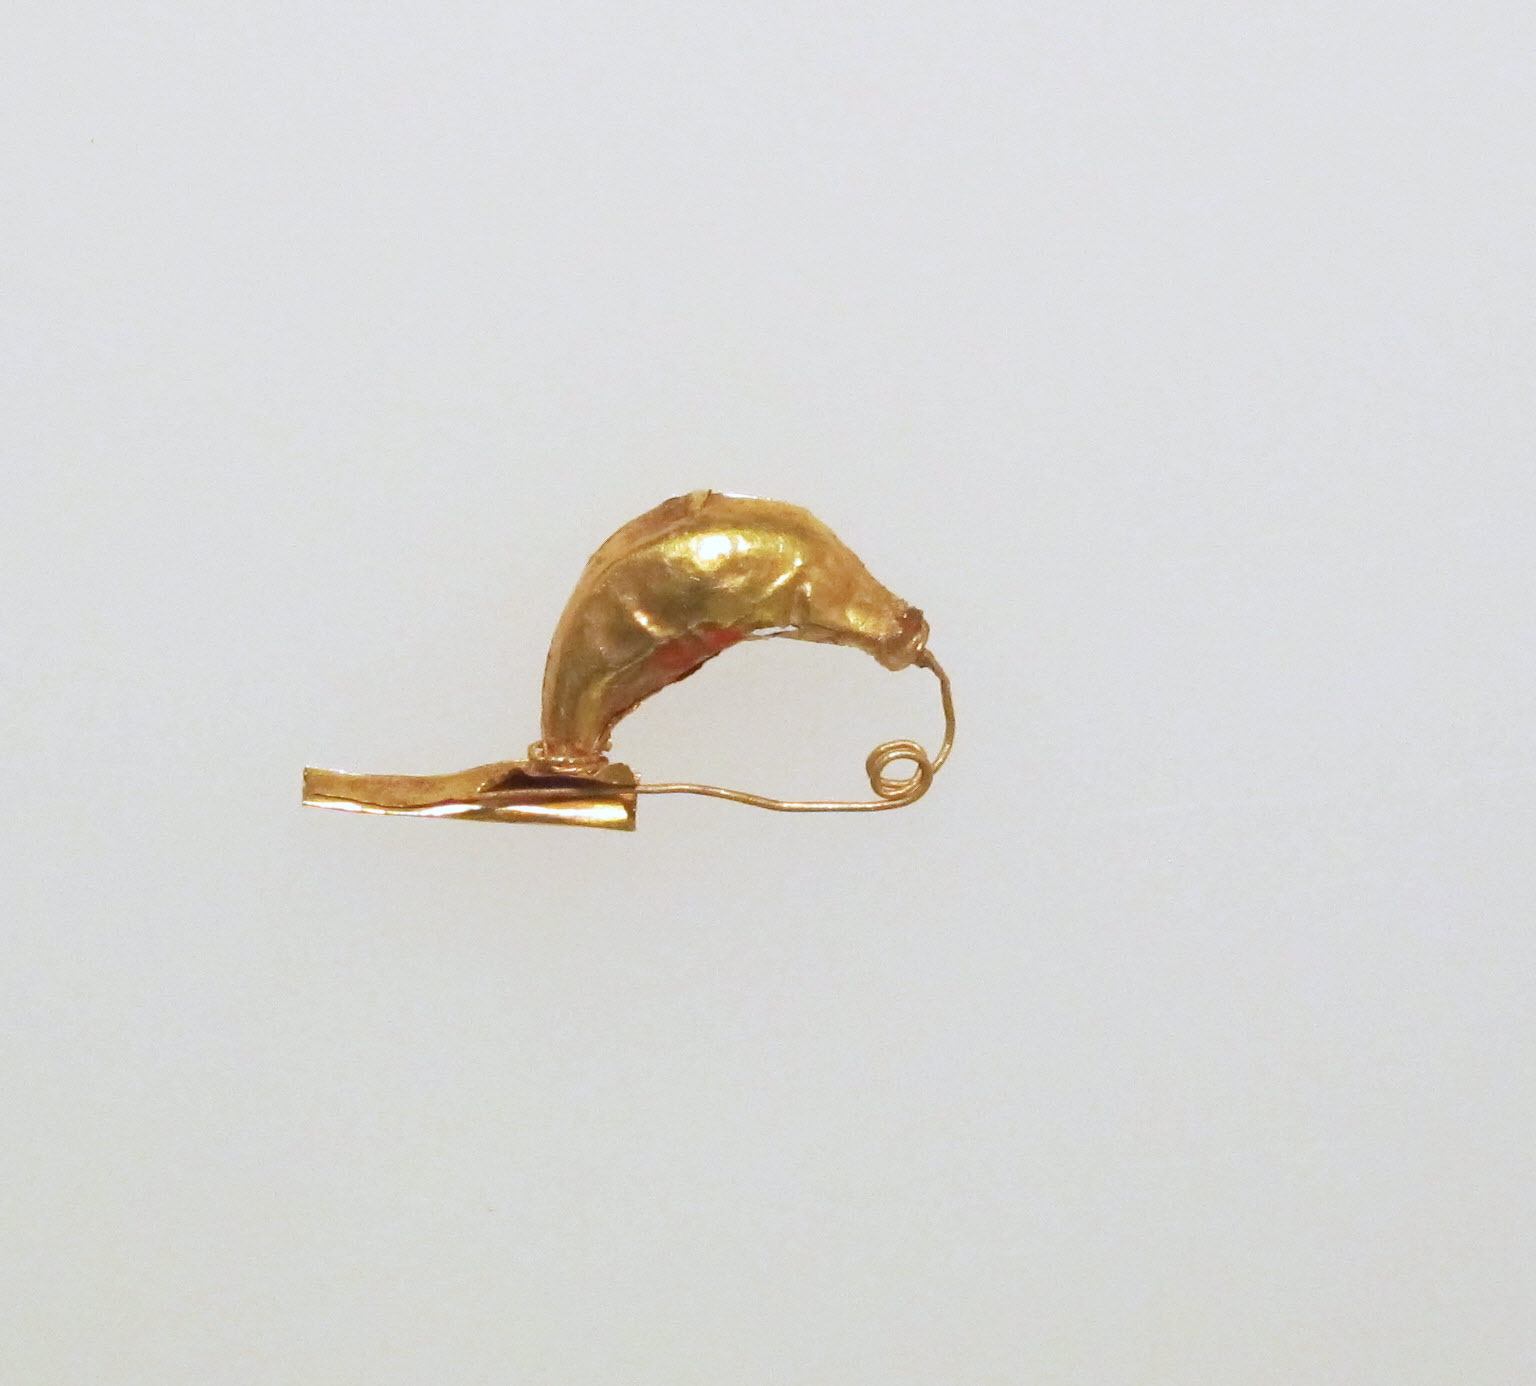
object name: fibula, bow shaped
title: Fibula, bow-shaped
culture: italic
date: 900-100 BCE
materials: gold